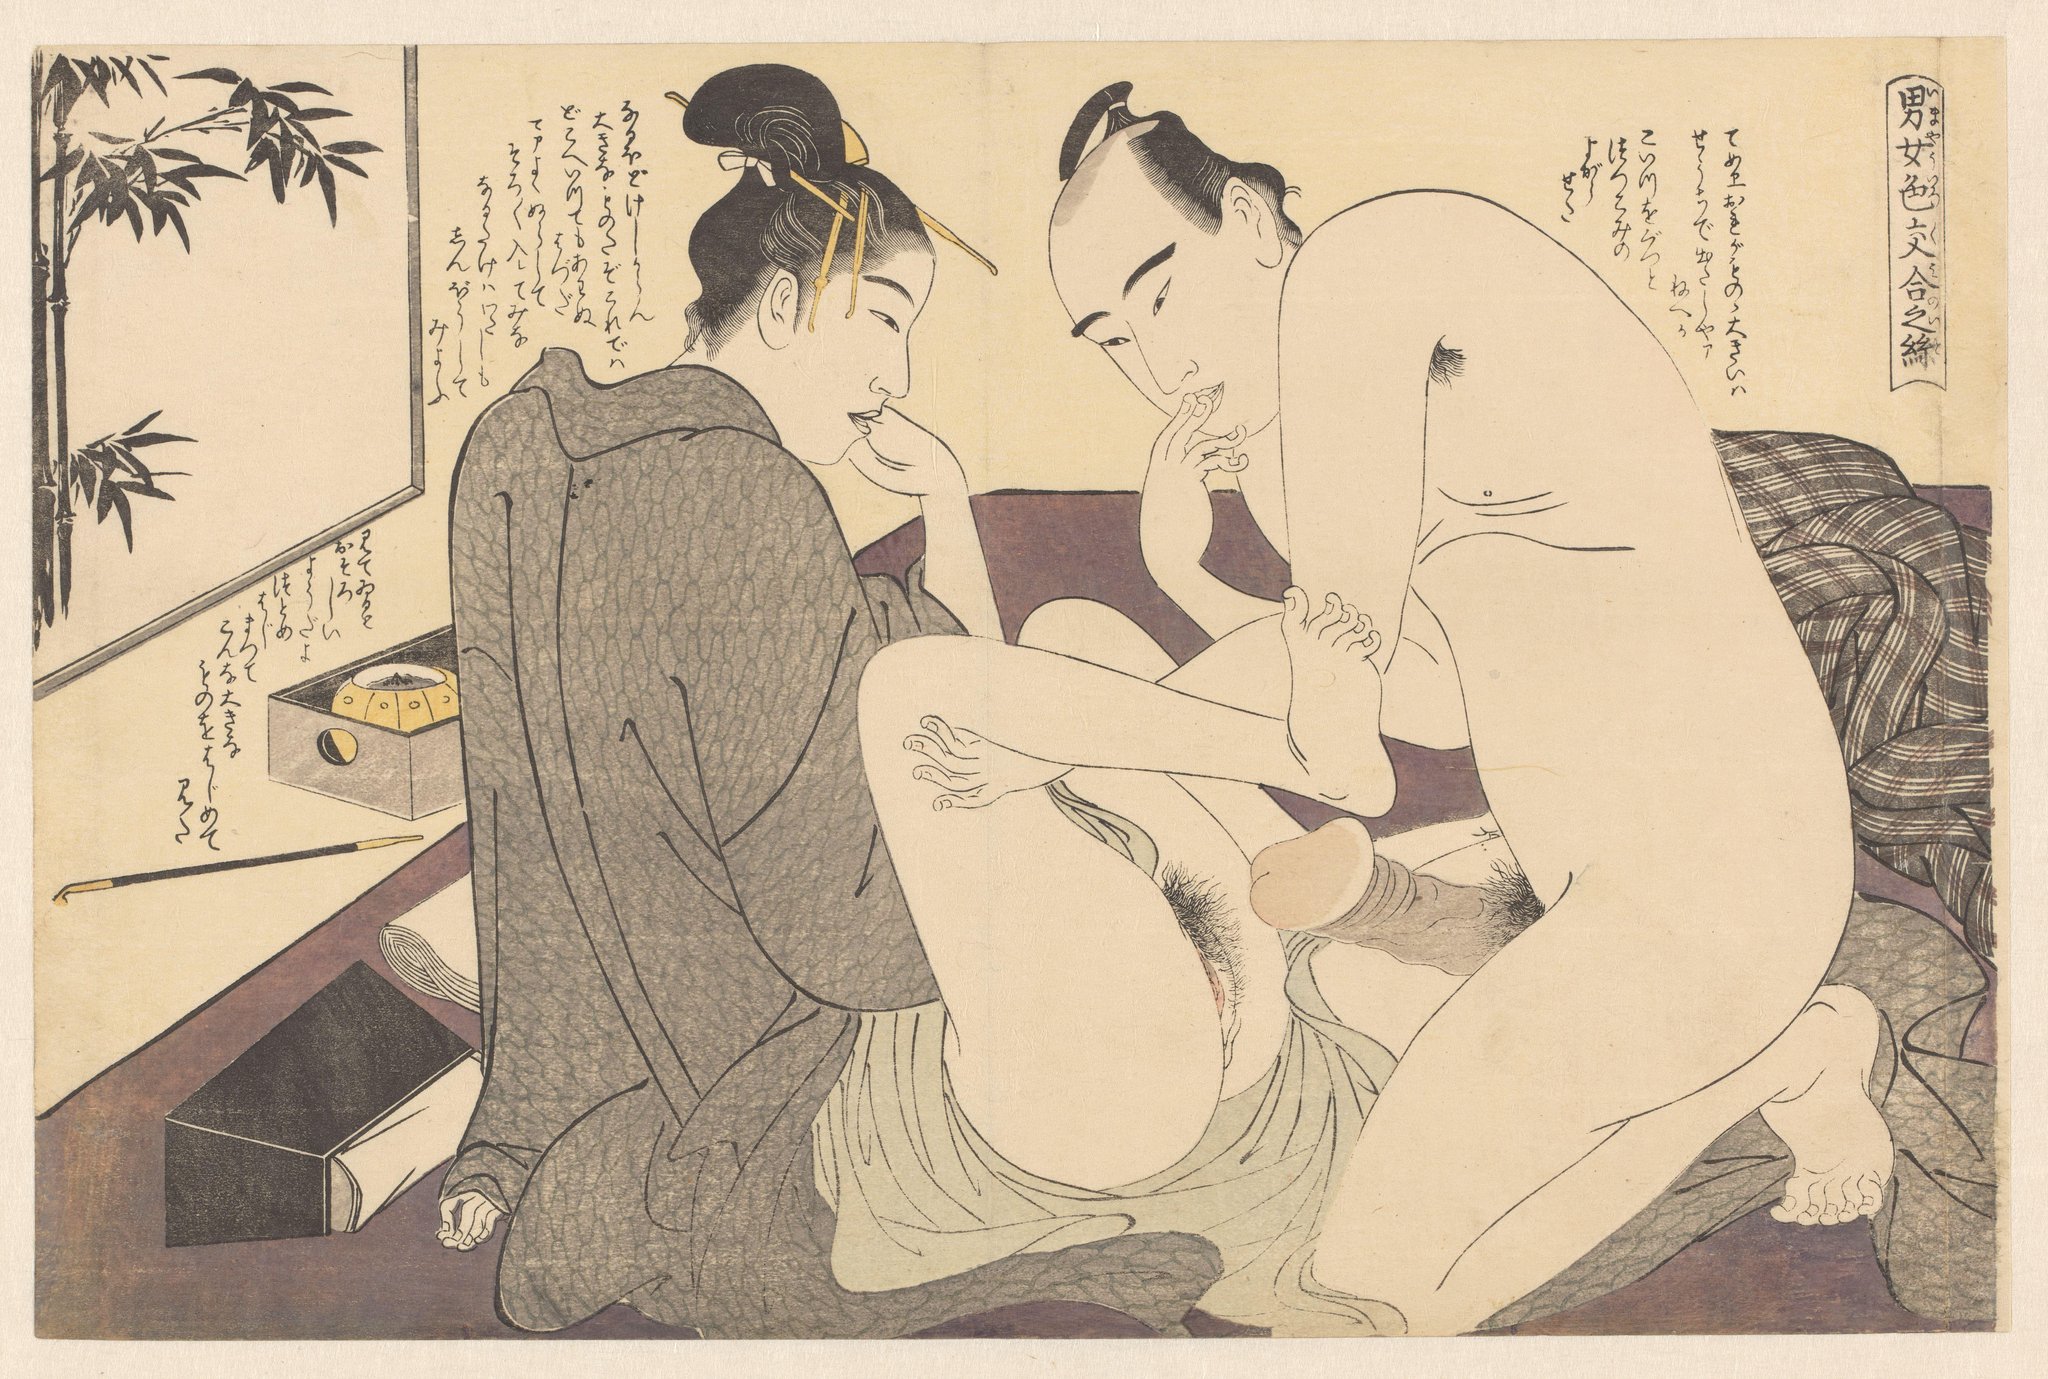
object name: shunga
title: Imayo irokumi no ito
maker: katsukawa shunchō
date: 1789-1790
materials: paper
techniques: woodcut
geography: japan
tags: man and woman cohabiting